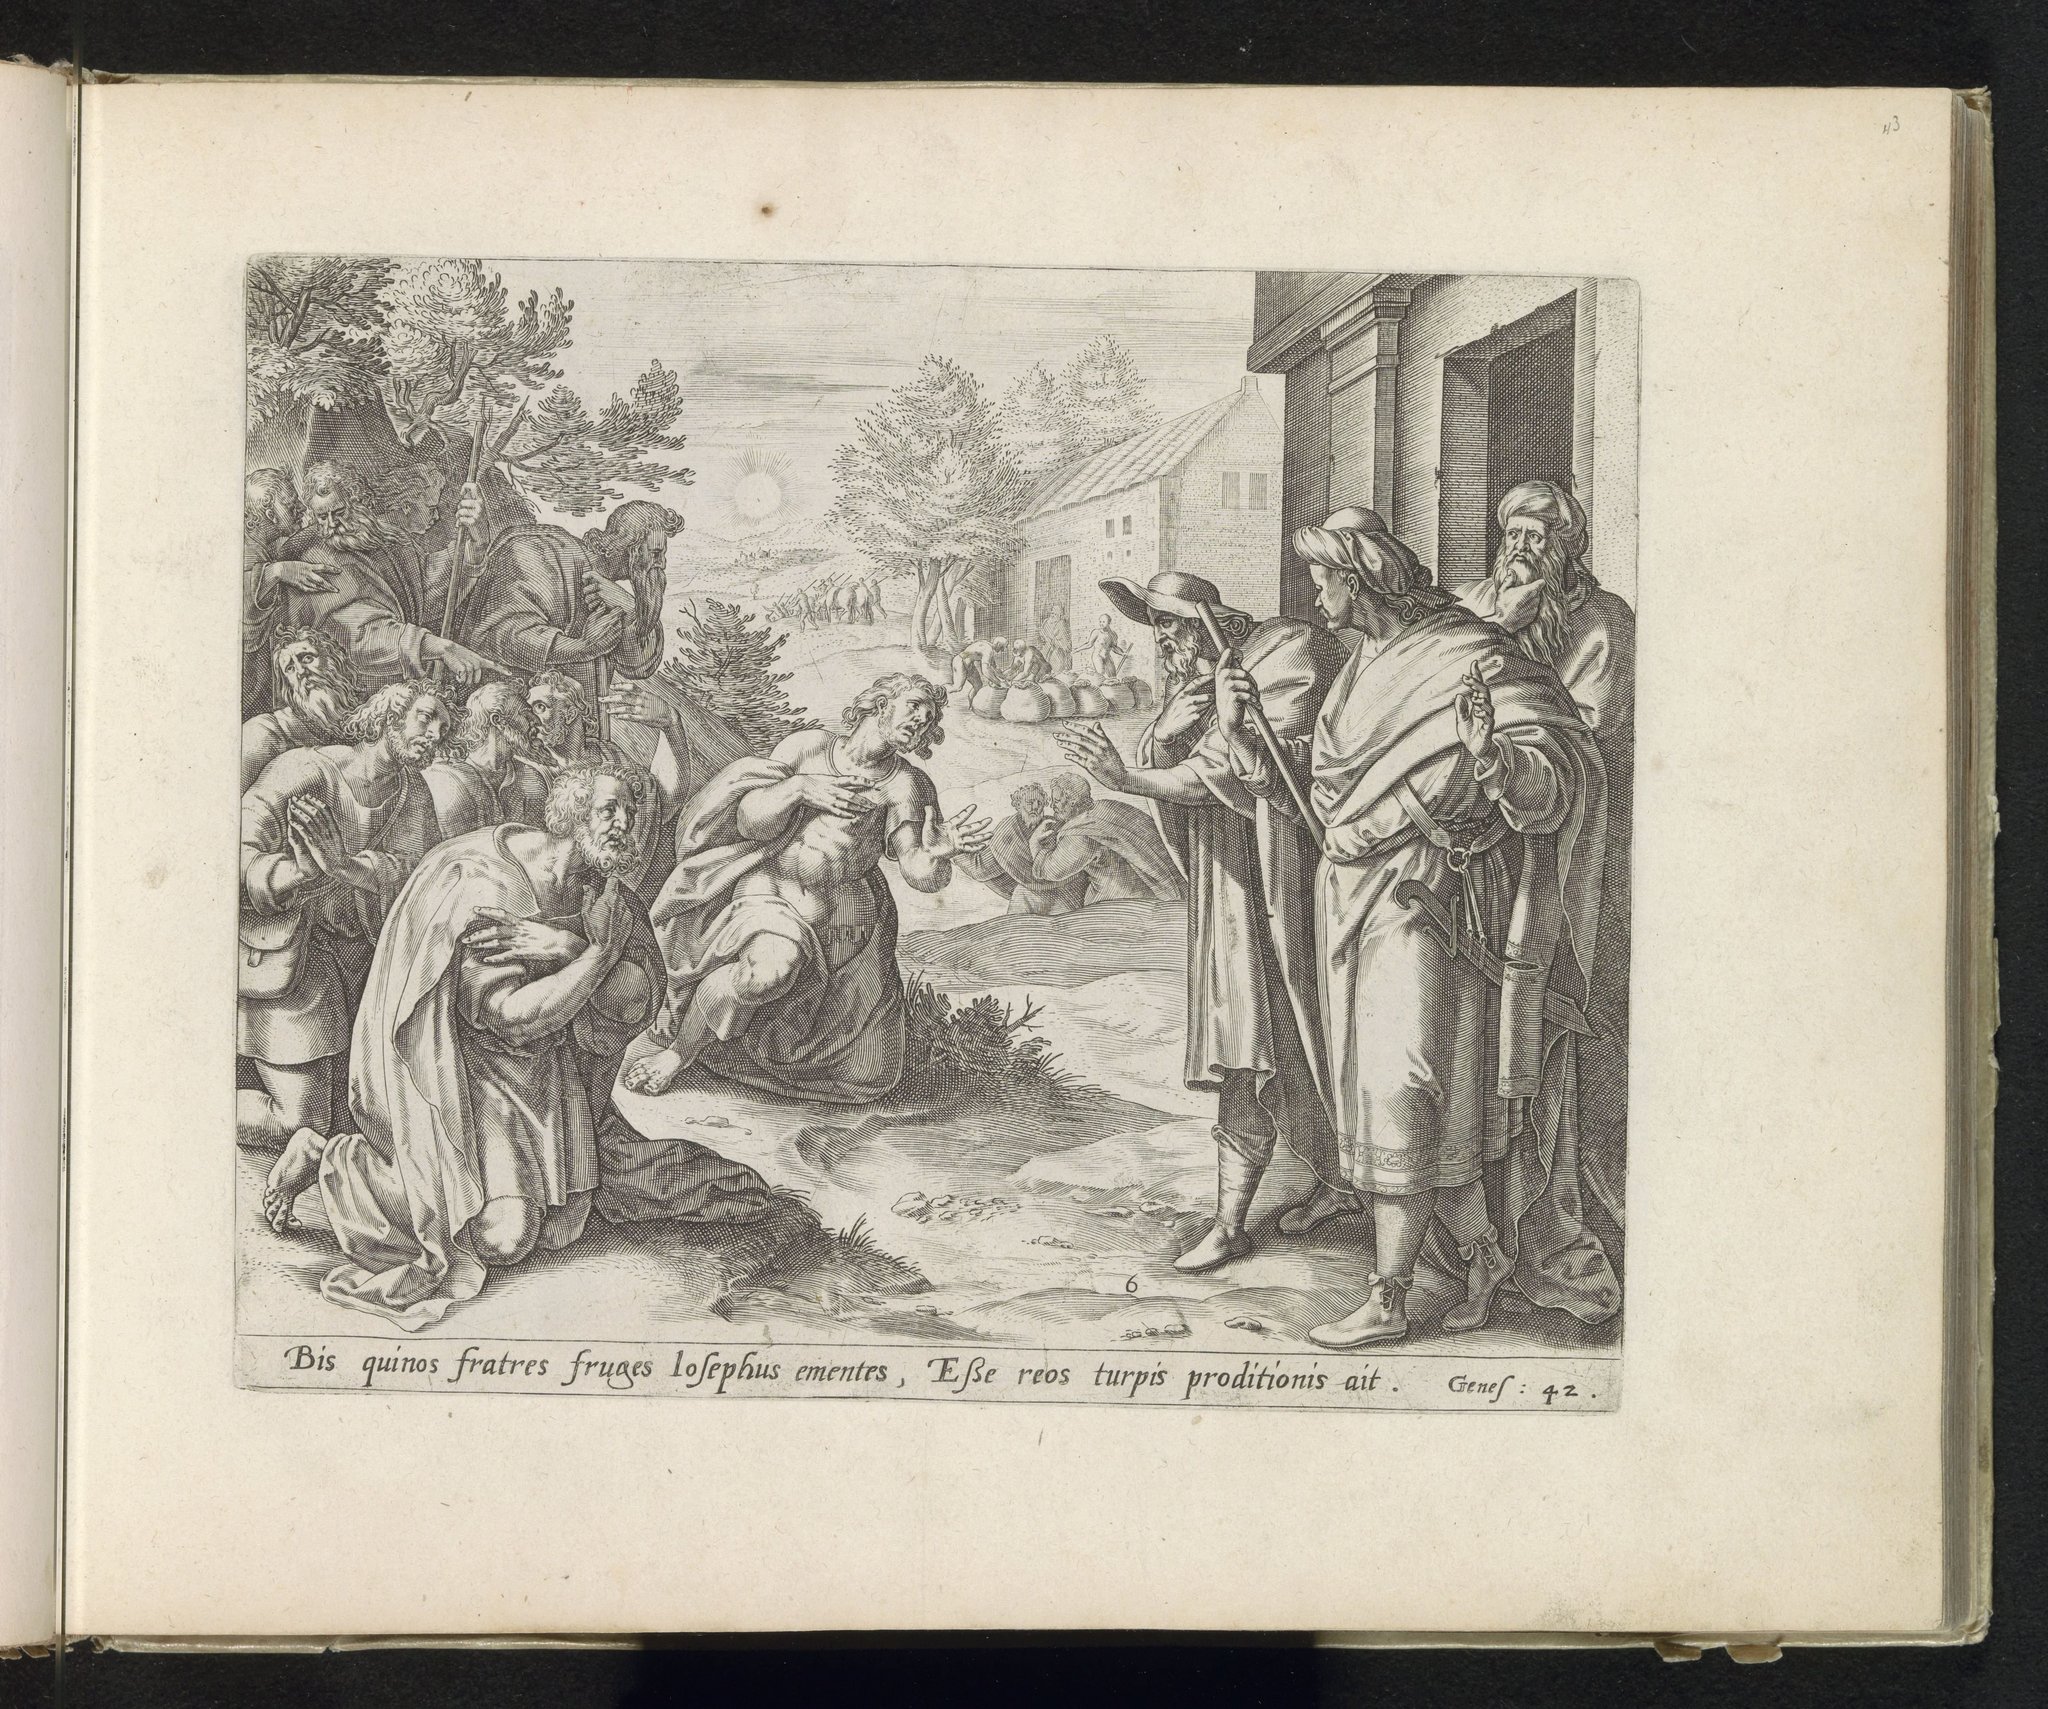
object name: print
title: Jozefs broers knielen voor Jozef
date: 1585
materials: paper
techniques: engraving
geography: antwerp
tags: joseph's brothers load their donkeys and leave egypt, admitted in joseph's presence, the brothers bow down before him, joseph's brothers are given corn; joseph orders money to be placed secretly in their sacks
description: Tien van Jozefs broers zijn naar Egypte gekomen om graan te kopen. Jozef, die rechts staat met een scepter in zijn hand, beschuldigt hen van spionage. De broers proberen aan Jozef, die ze niet als hun broer herkennen, uit te leggen wie ze zijn. Jozef laat ze gaan, maar eist van hen dat ze terugkomen met hun jongste broer Benjamin. Op de achtergrond staat een aantal broers bij de zakken met graan. Geheel op de achtergrond vertrekken ze met hun ezels. Onder de voorstelling een verwijzing in het Latijn naar de Bijbeltekst in Gen. 42. Deze prent maakt deel uit van een album.